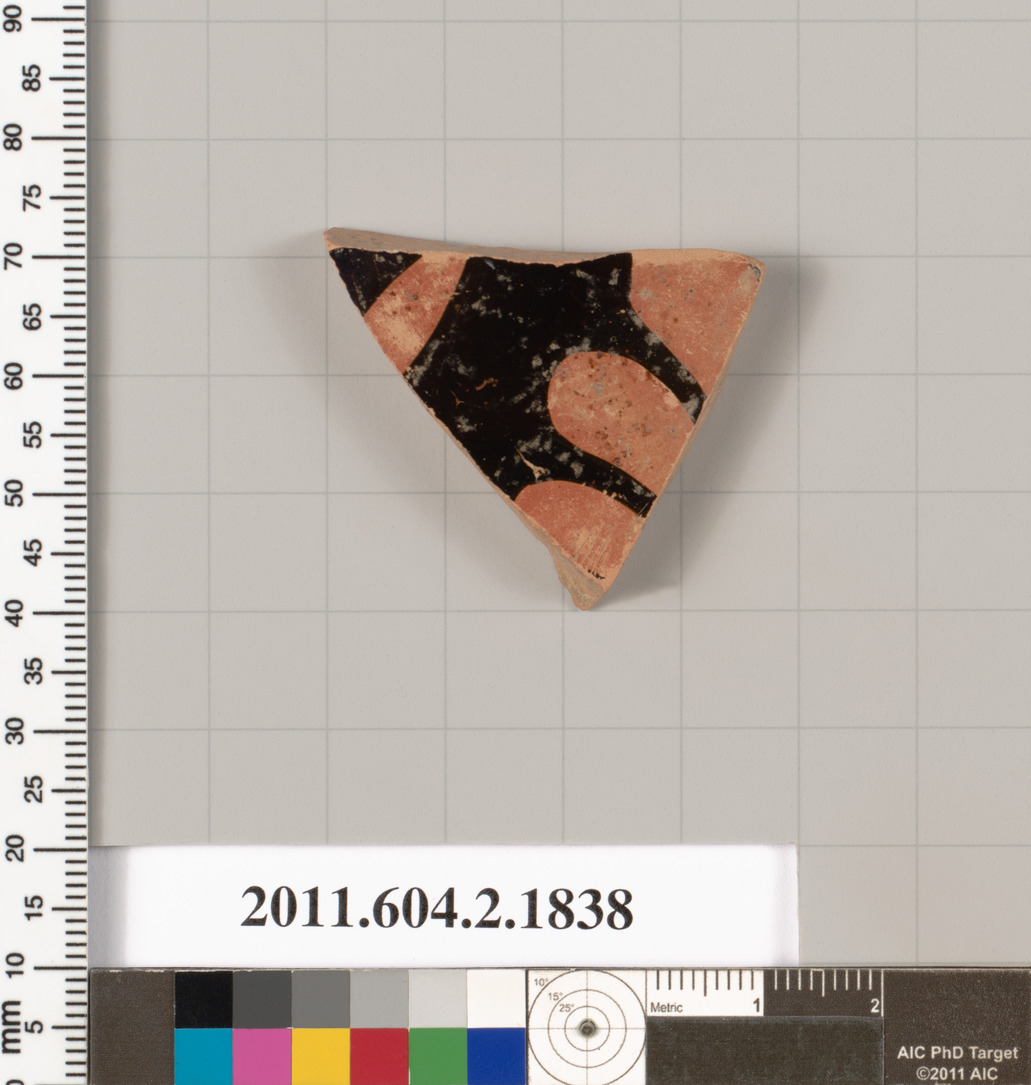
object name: skyphos fragment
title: Terracotta fragment of a skyphos (deep drinking cup)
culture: greek, attic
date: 450-426 BCE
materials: terracotta